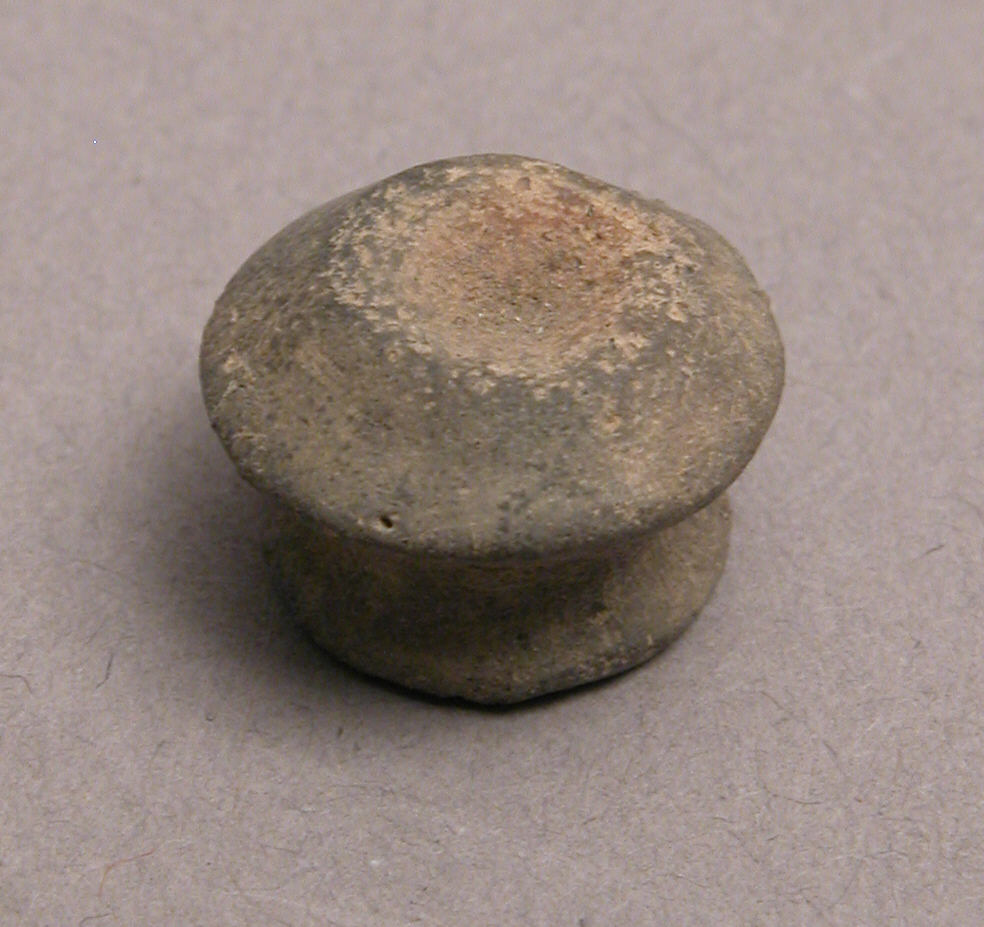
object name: game piece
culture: coptic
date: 301-700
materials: earthenware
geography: egypt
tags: games